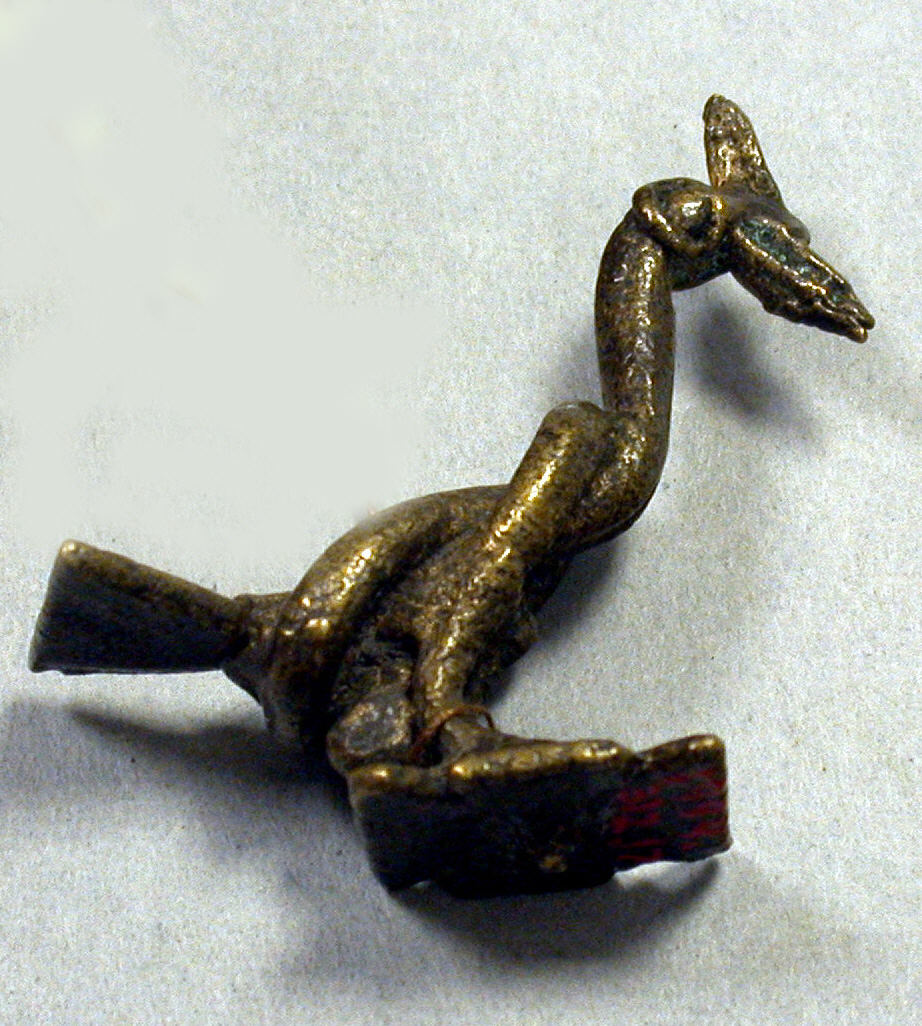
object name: weight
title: Gold Weight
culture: akan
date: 1701-1900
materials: brass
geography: ghana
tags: birds